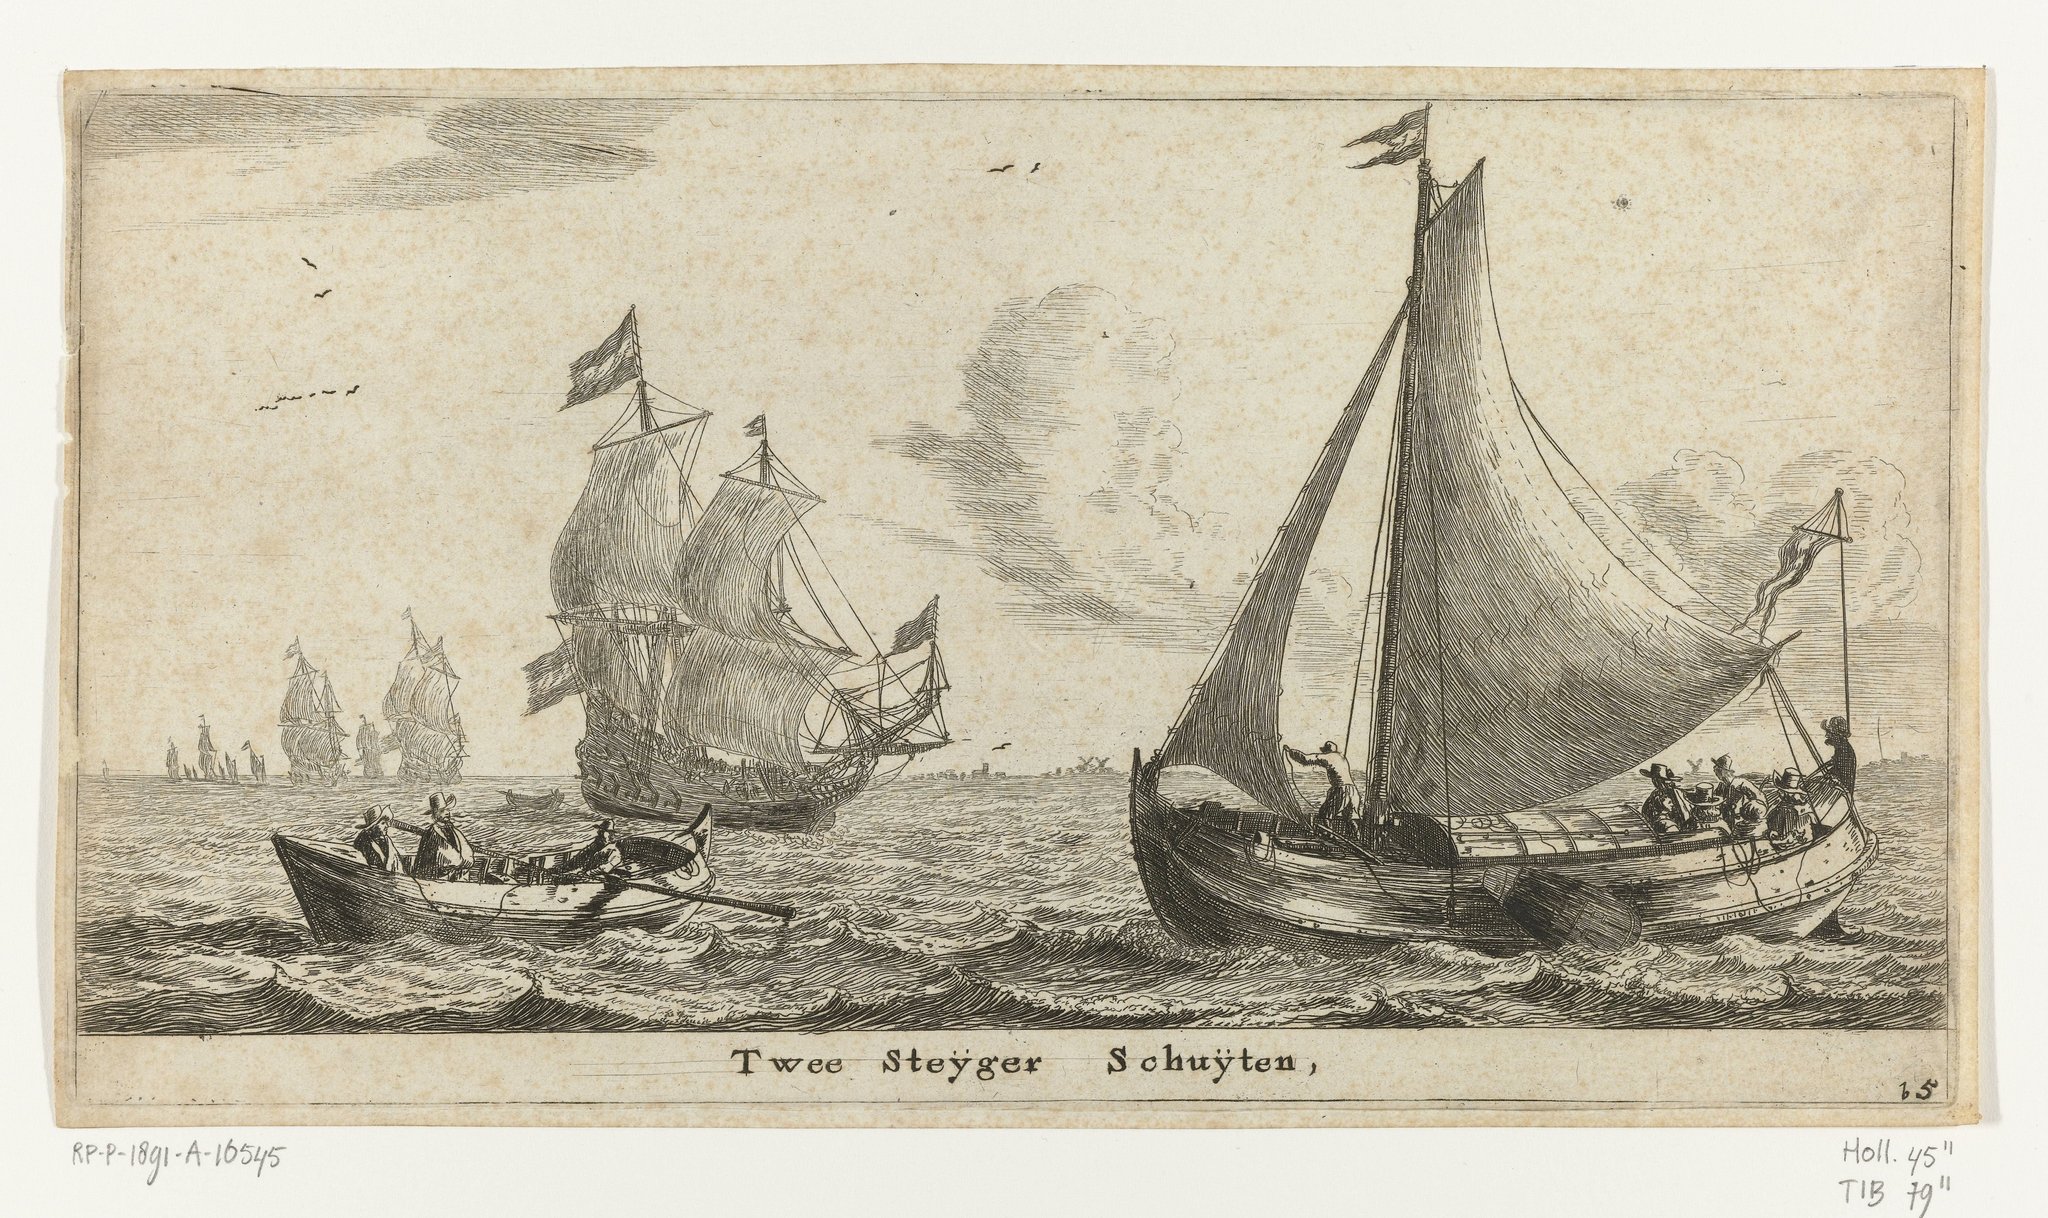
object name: print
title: Twee steigerschuiten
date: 1652-1654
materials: paper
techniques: drypoint, etching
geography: netherlands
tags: ships (in general)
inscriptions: collector's mark: Lugt 2228, collector's mark: Lugt 1227, collector's mark: Lugt 1494, collector's mark: Lugt 462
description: Prent uit serie Verscheyde Schepen en Gesichten van Amstelredam met twaalf prenten. Type schip volgens de titel maar een dergelijke schuit was waarschijnlijk veel platter en werd met haken en bomen voortbewogen en niet, zoals hier met riemen of zeilen.